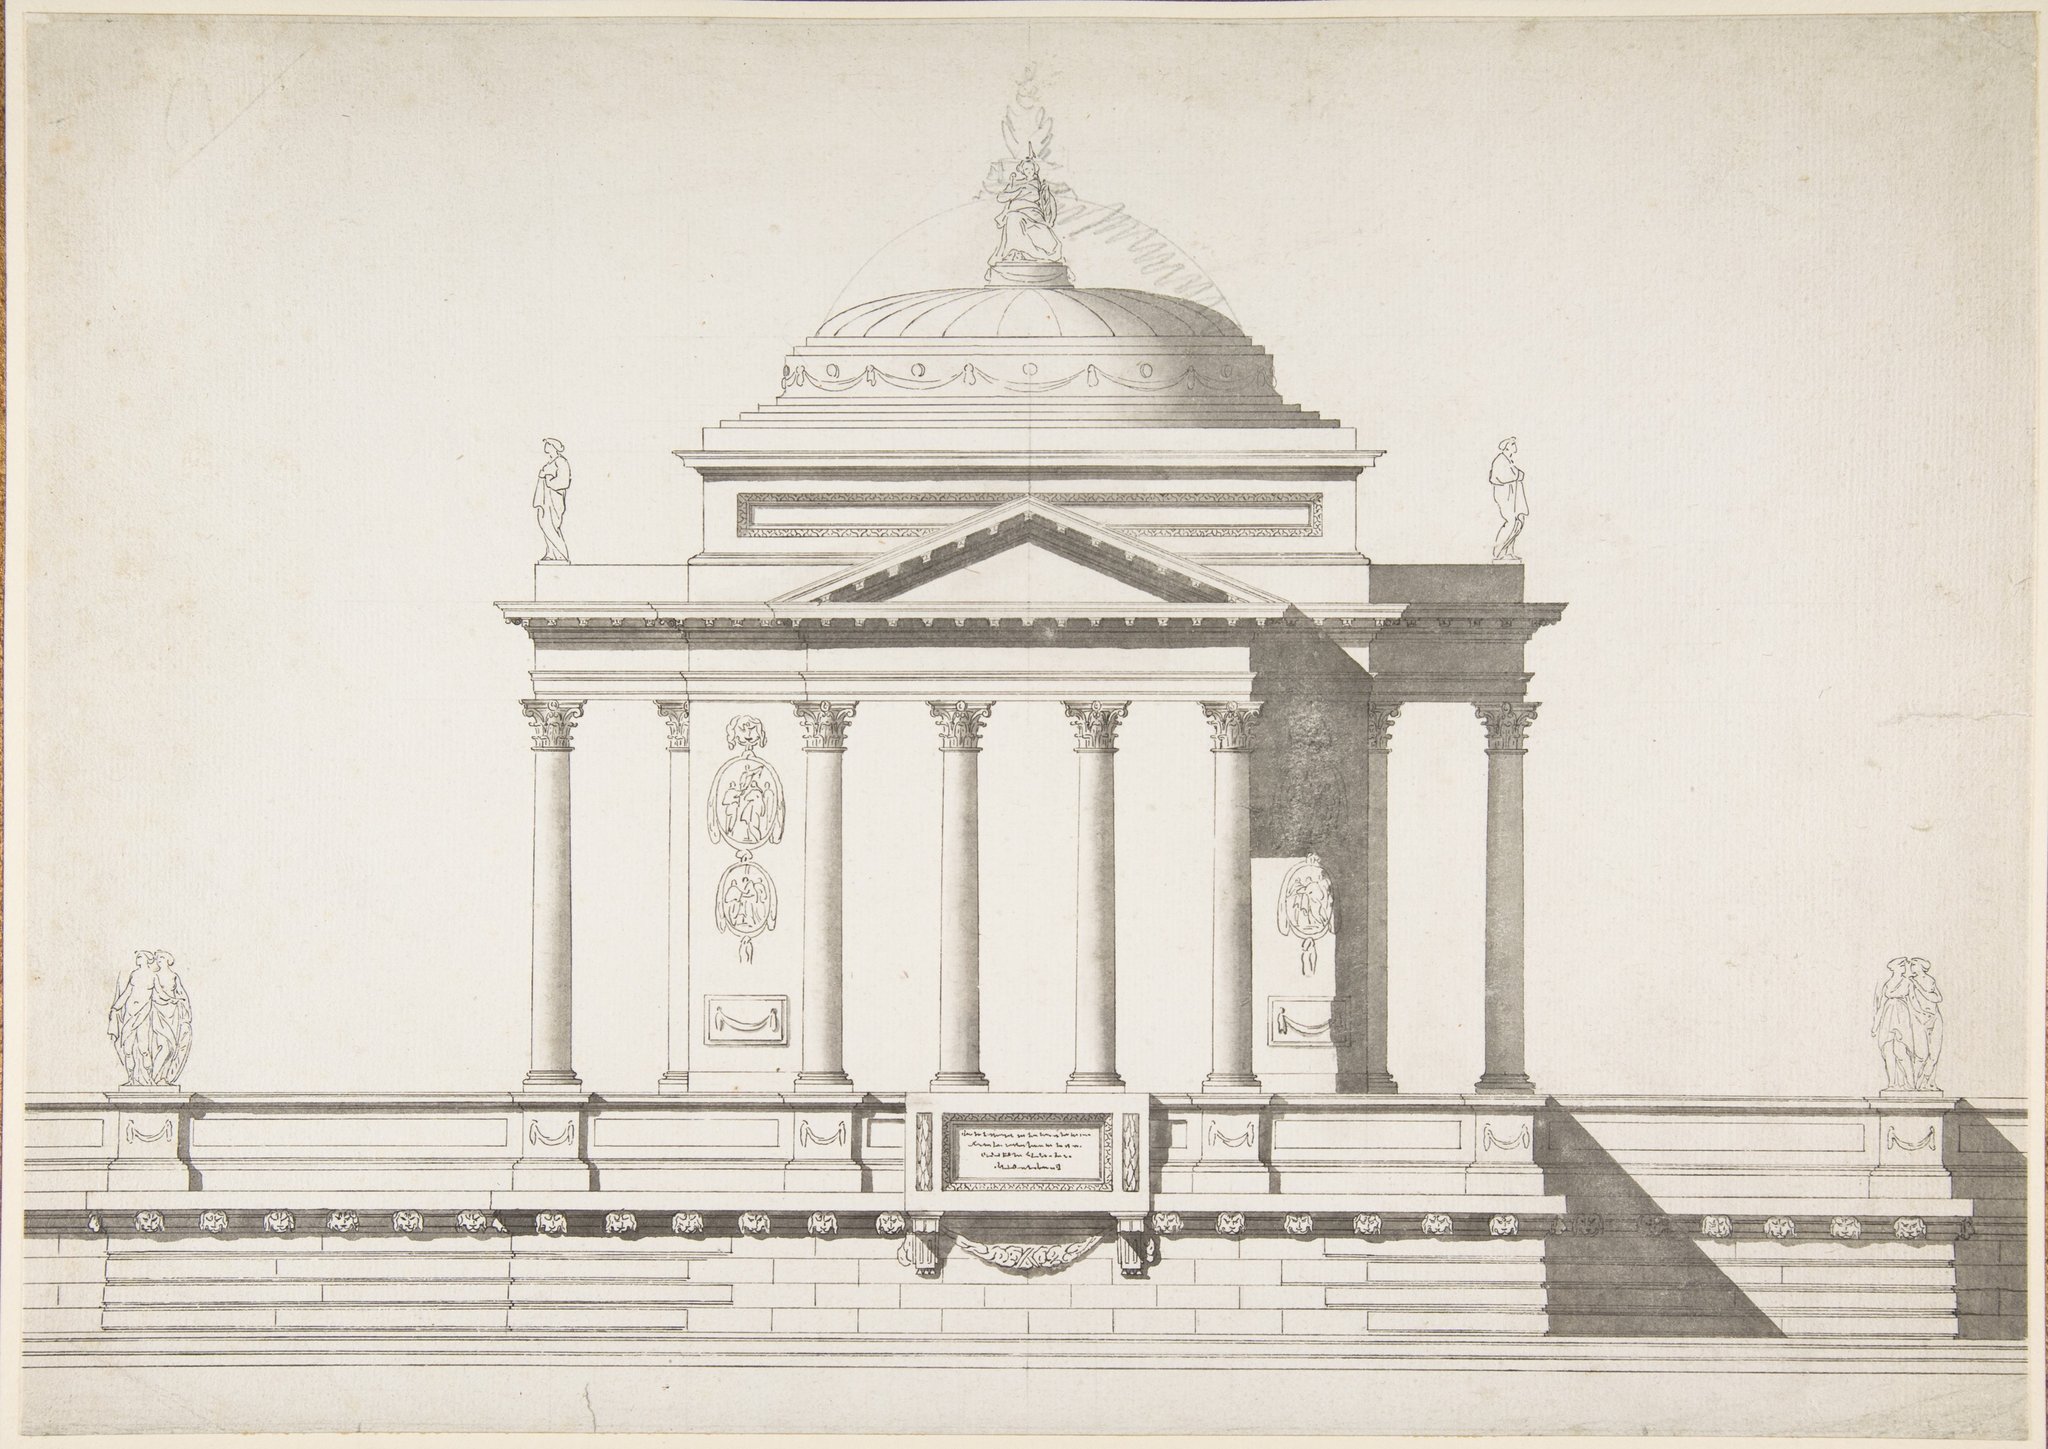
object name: drawing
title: Elevation of a Domed Corinthian Temple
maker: anonymous, french, 18th century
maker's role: artist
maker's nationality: french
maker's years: 1700-1800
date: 1701-1800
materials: graphite, ink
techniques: brush, pen, wash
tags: architecture,temples